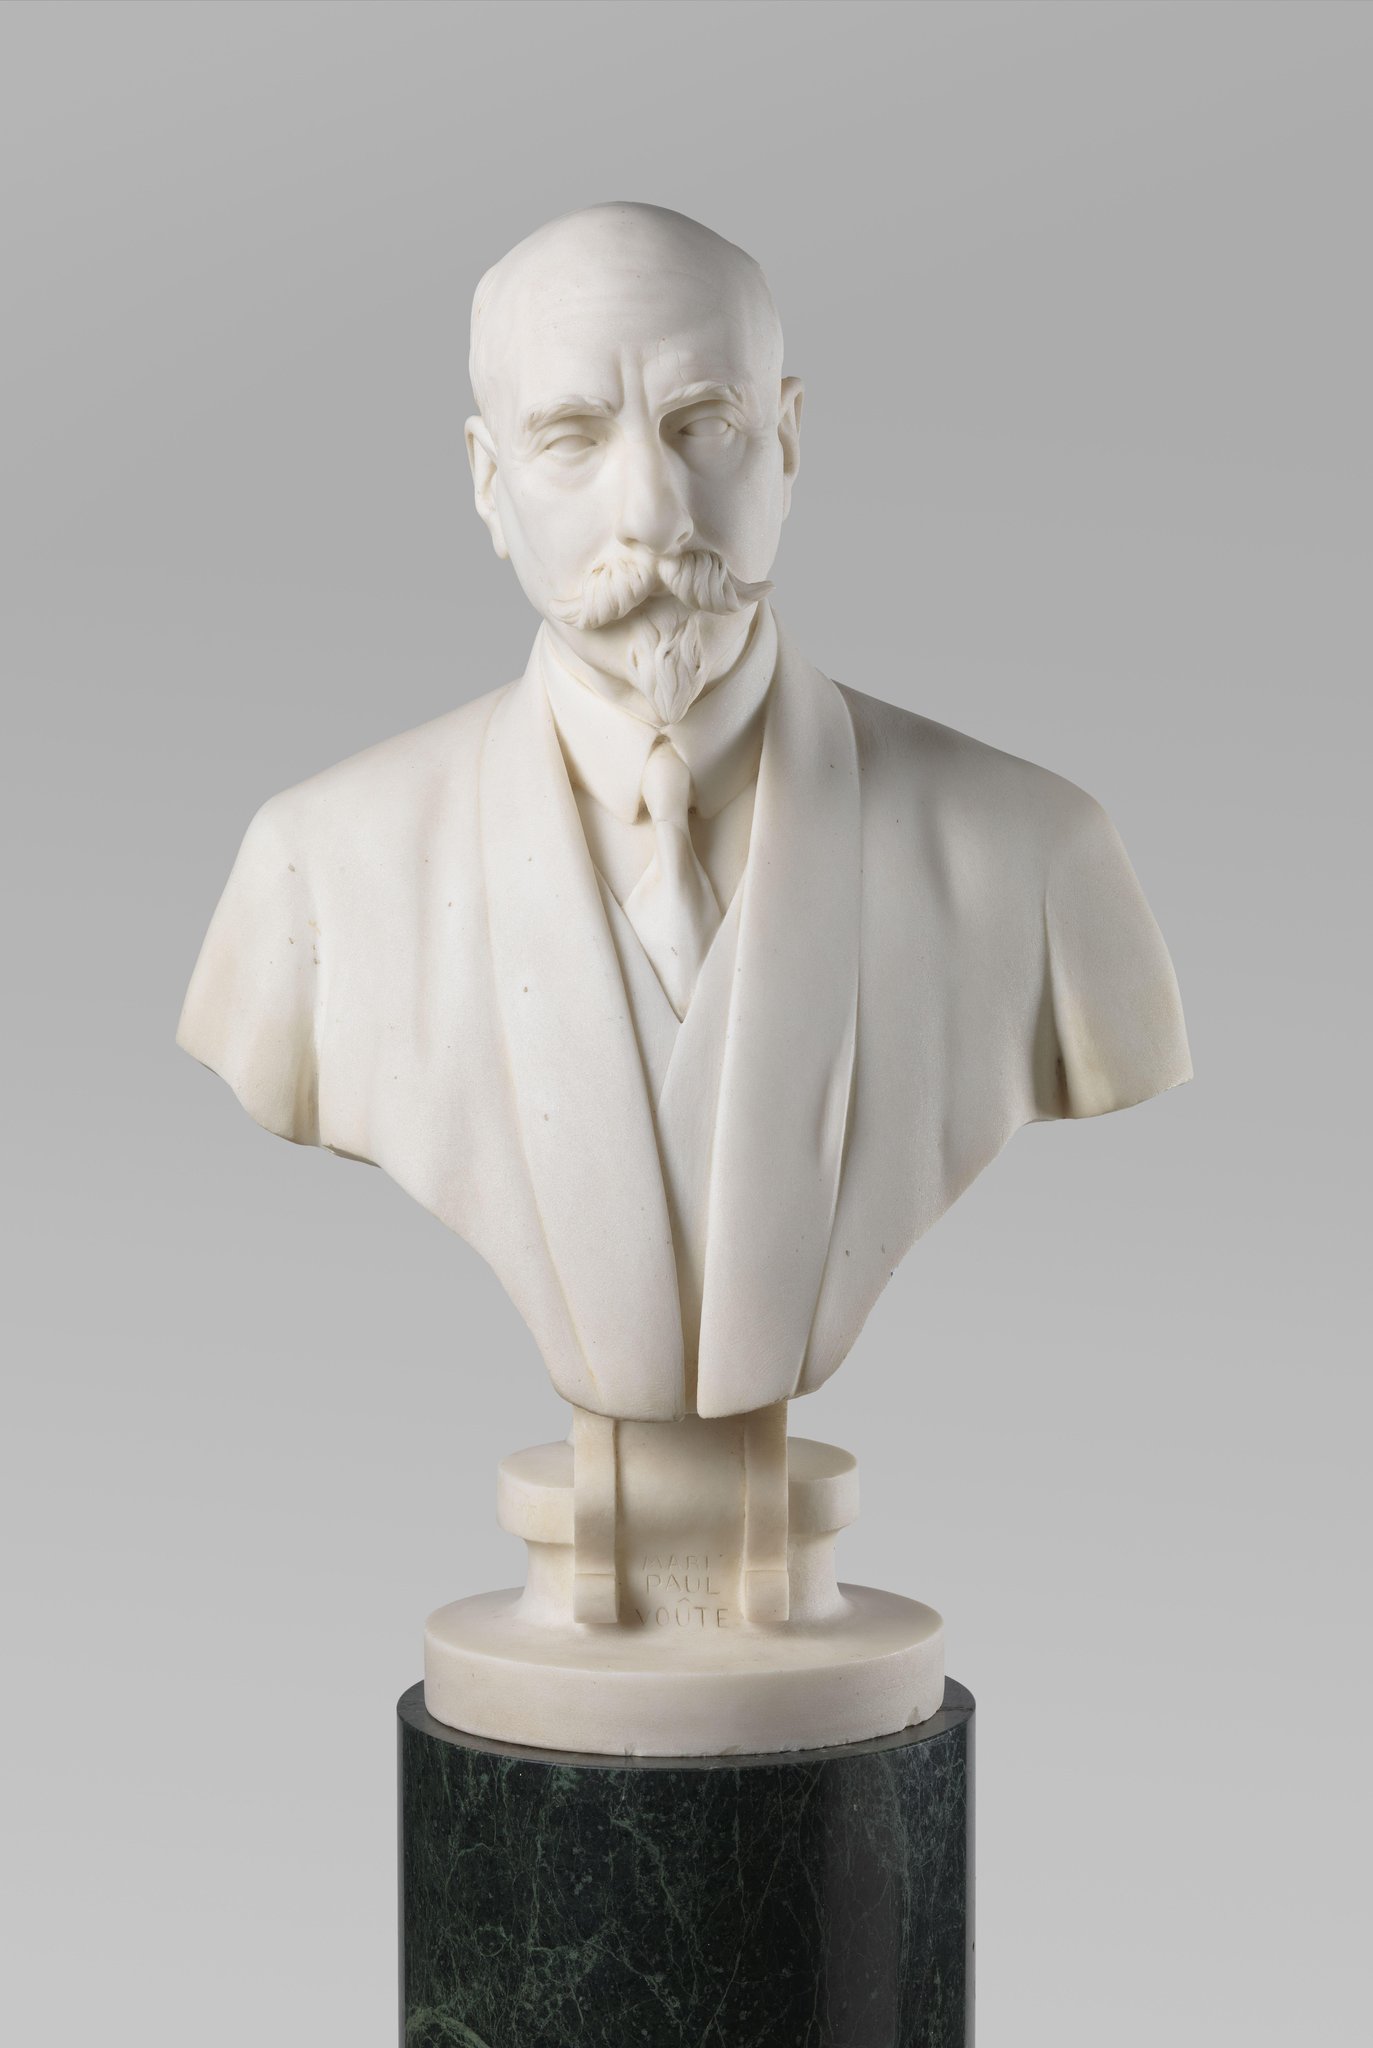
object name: bust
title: Buste van de heer M.P. Voûte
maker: maja van panhuys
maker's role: draughtsman, sculptor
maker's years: 1870-1944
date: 1927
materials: marble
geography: rome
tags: mari paul voûte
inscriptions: date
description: Frontaal borstbeeld van een kale heer met snor en sikbaard, en het hoofd licht zijwaarts geknikt, rustend op voluutvormige steun, die eindigt in een ronde getrapte voet. Inscriptie op de voluut: PAUL VOUTE en gesigneerd: Fecit Maja Serger van Panhuys, Roma 1927. Bij de buste hoort een sokkel (BK-2016-15-2 en -3).